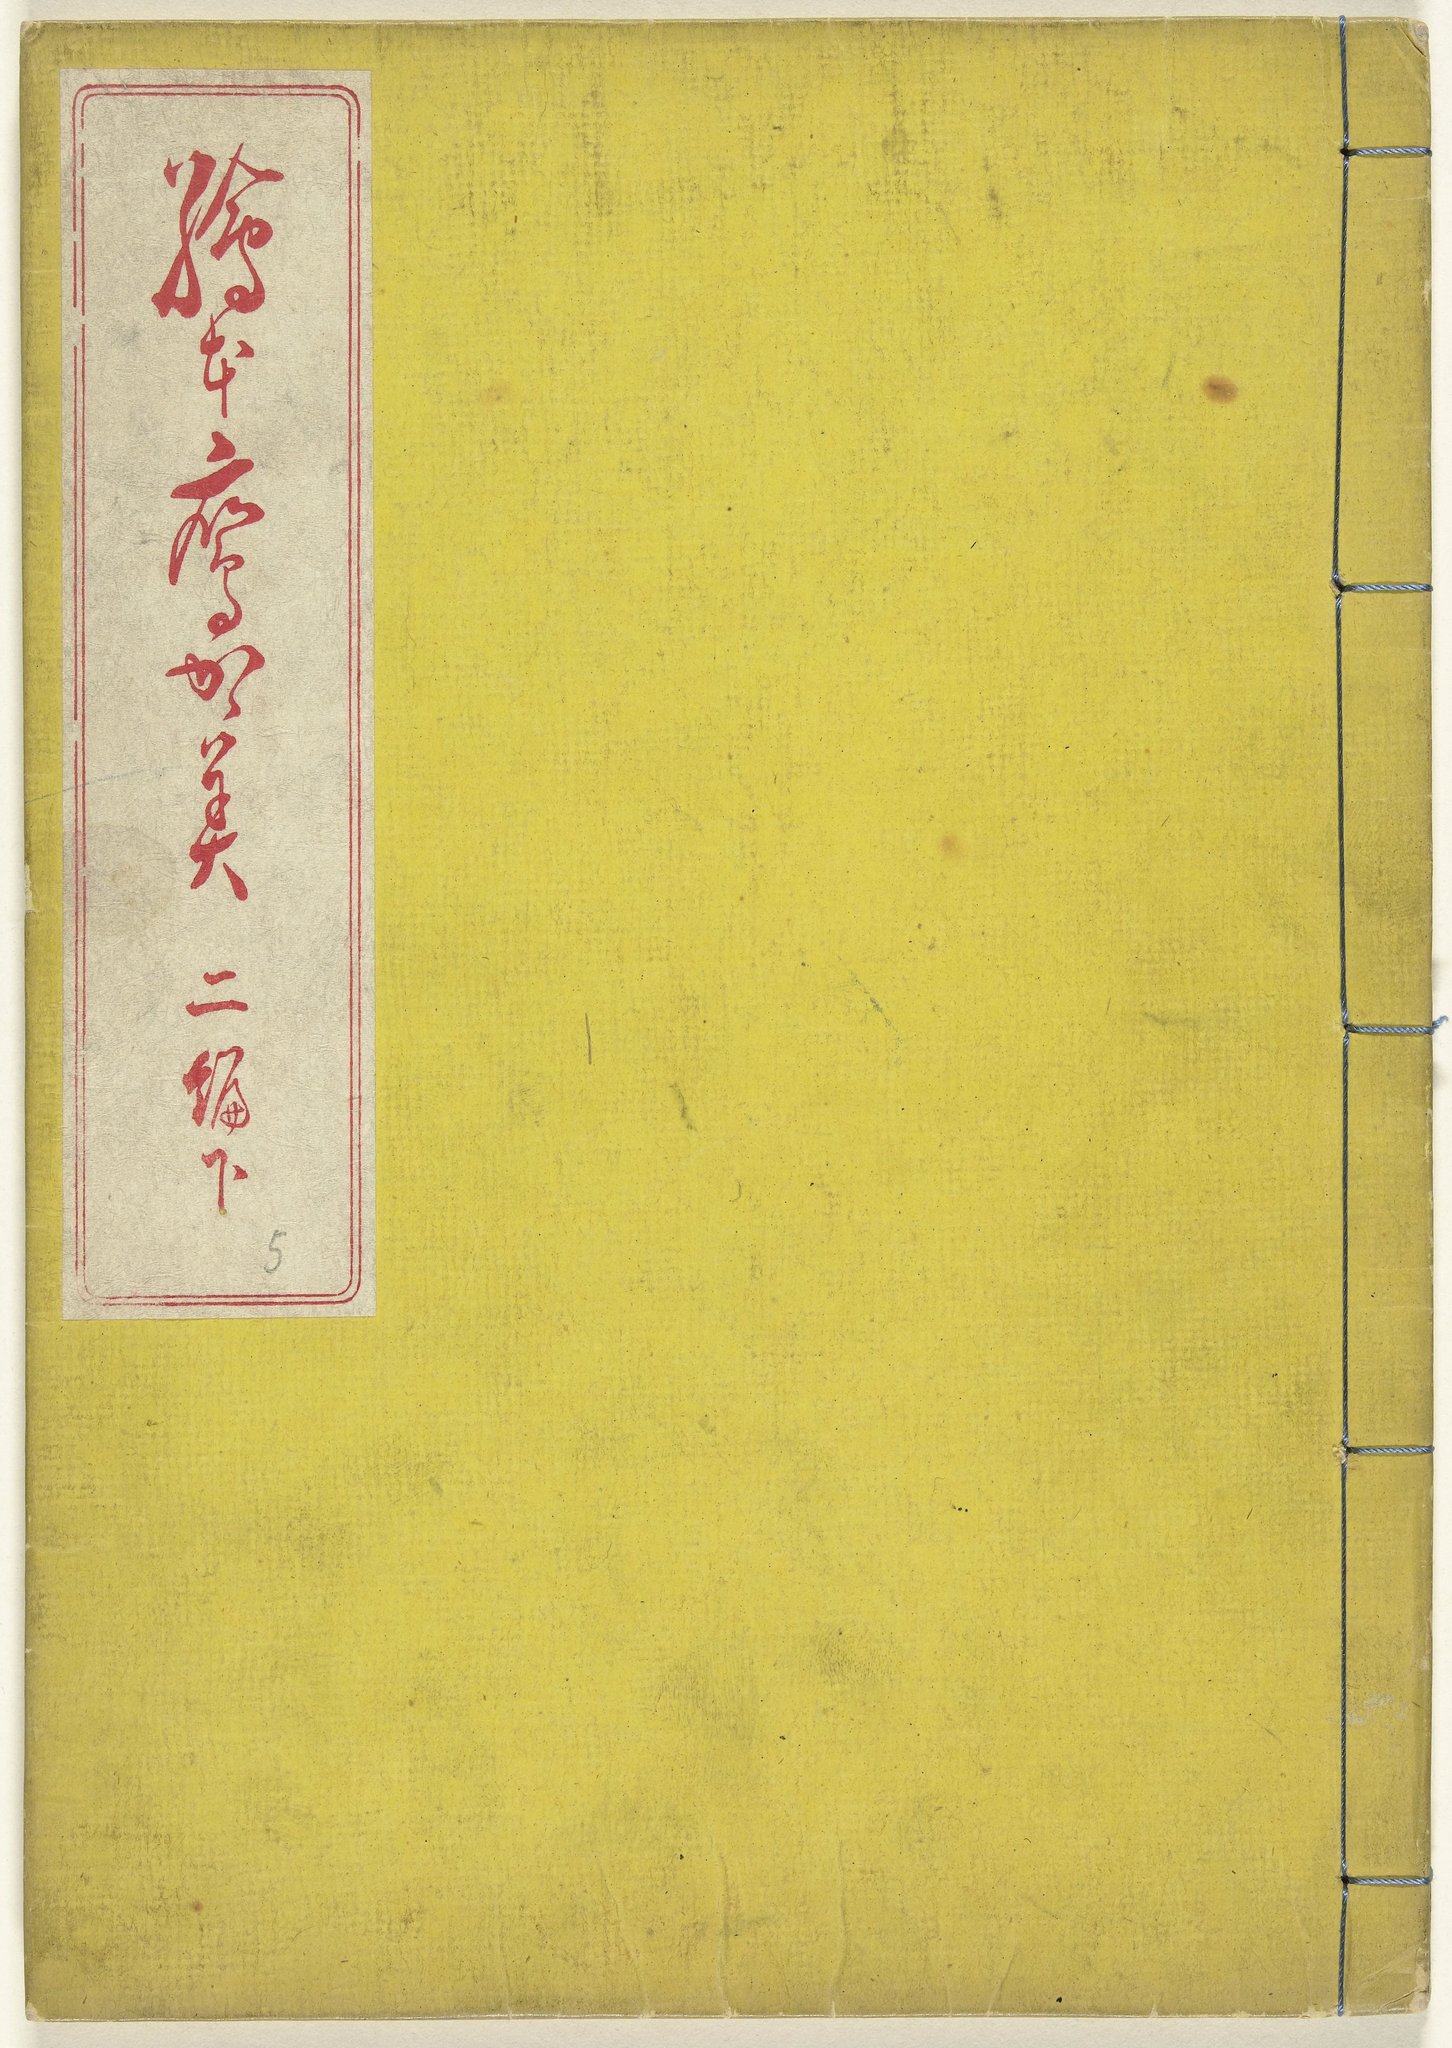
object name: book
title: Ehon taka kagami - nihen ge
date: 1877-1879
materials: paper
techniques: woodcut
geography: tokyo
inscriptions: collector's mark: Lugt 2228